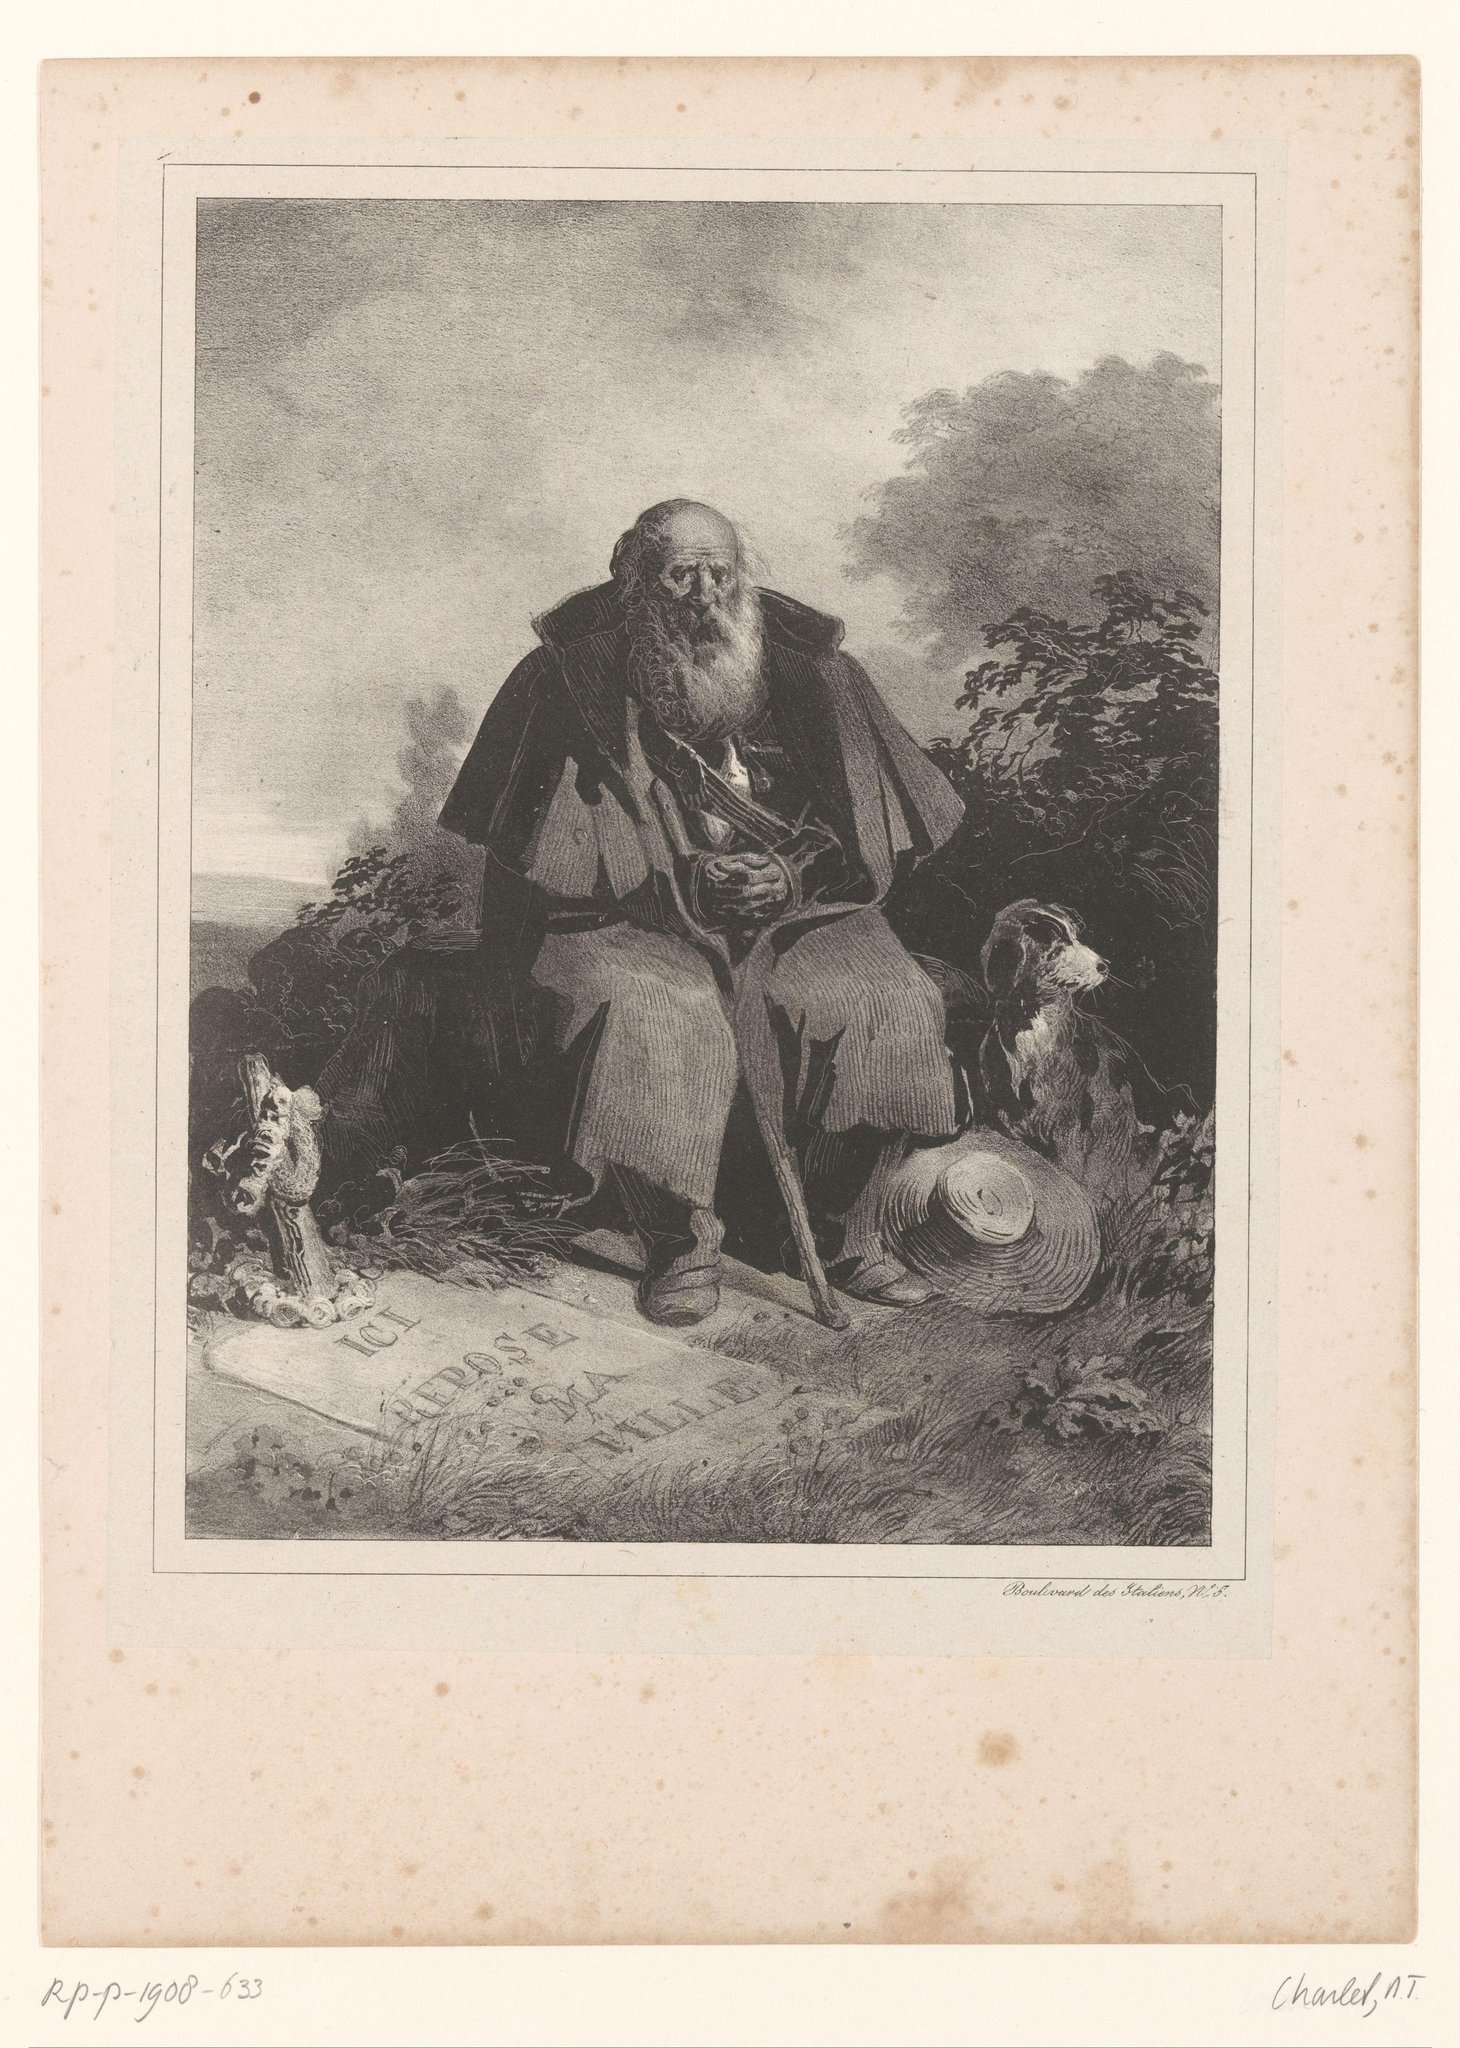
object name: print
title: Oude man bij het graf van zijn dochter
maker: nicolas toussaint charlet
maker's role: draughtsman, painter, print maker, printer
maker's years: 1792-1845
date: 1829-1839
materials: paper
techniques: lithograph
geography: paris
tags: old man, care and visitation of burial place, flat, horizontal gravestone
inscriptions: collector's mark: Lugt 2228a